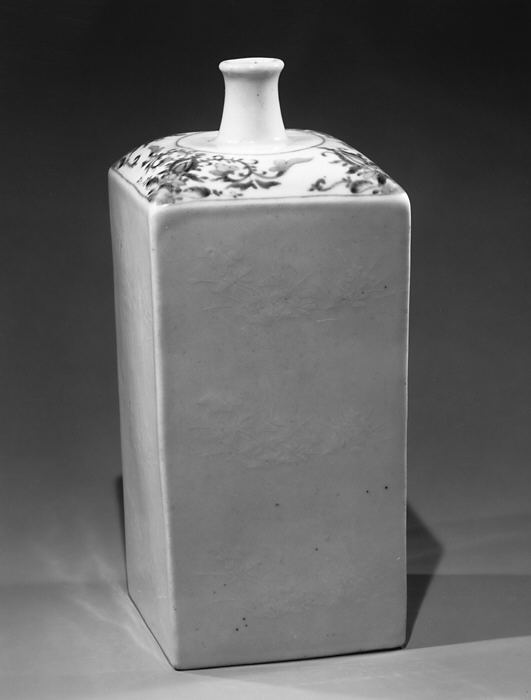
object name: wine bottle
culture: japanese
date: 1667-1700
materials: porcelain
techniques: underglaze